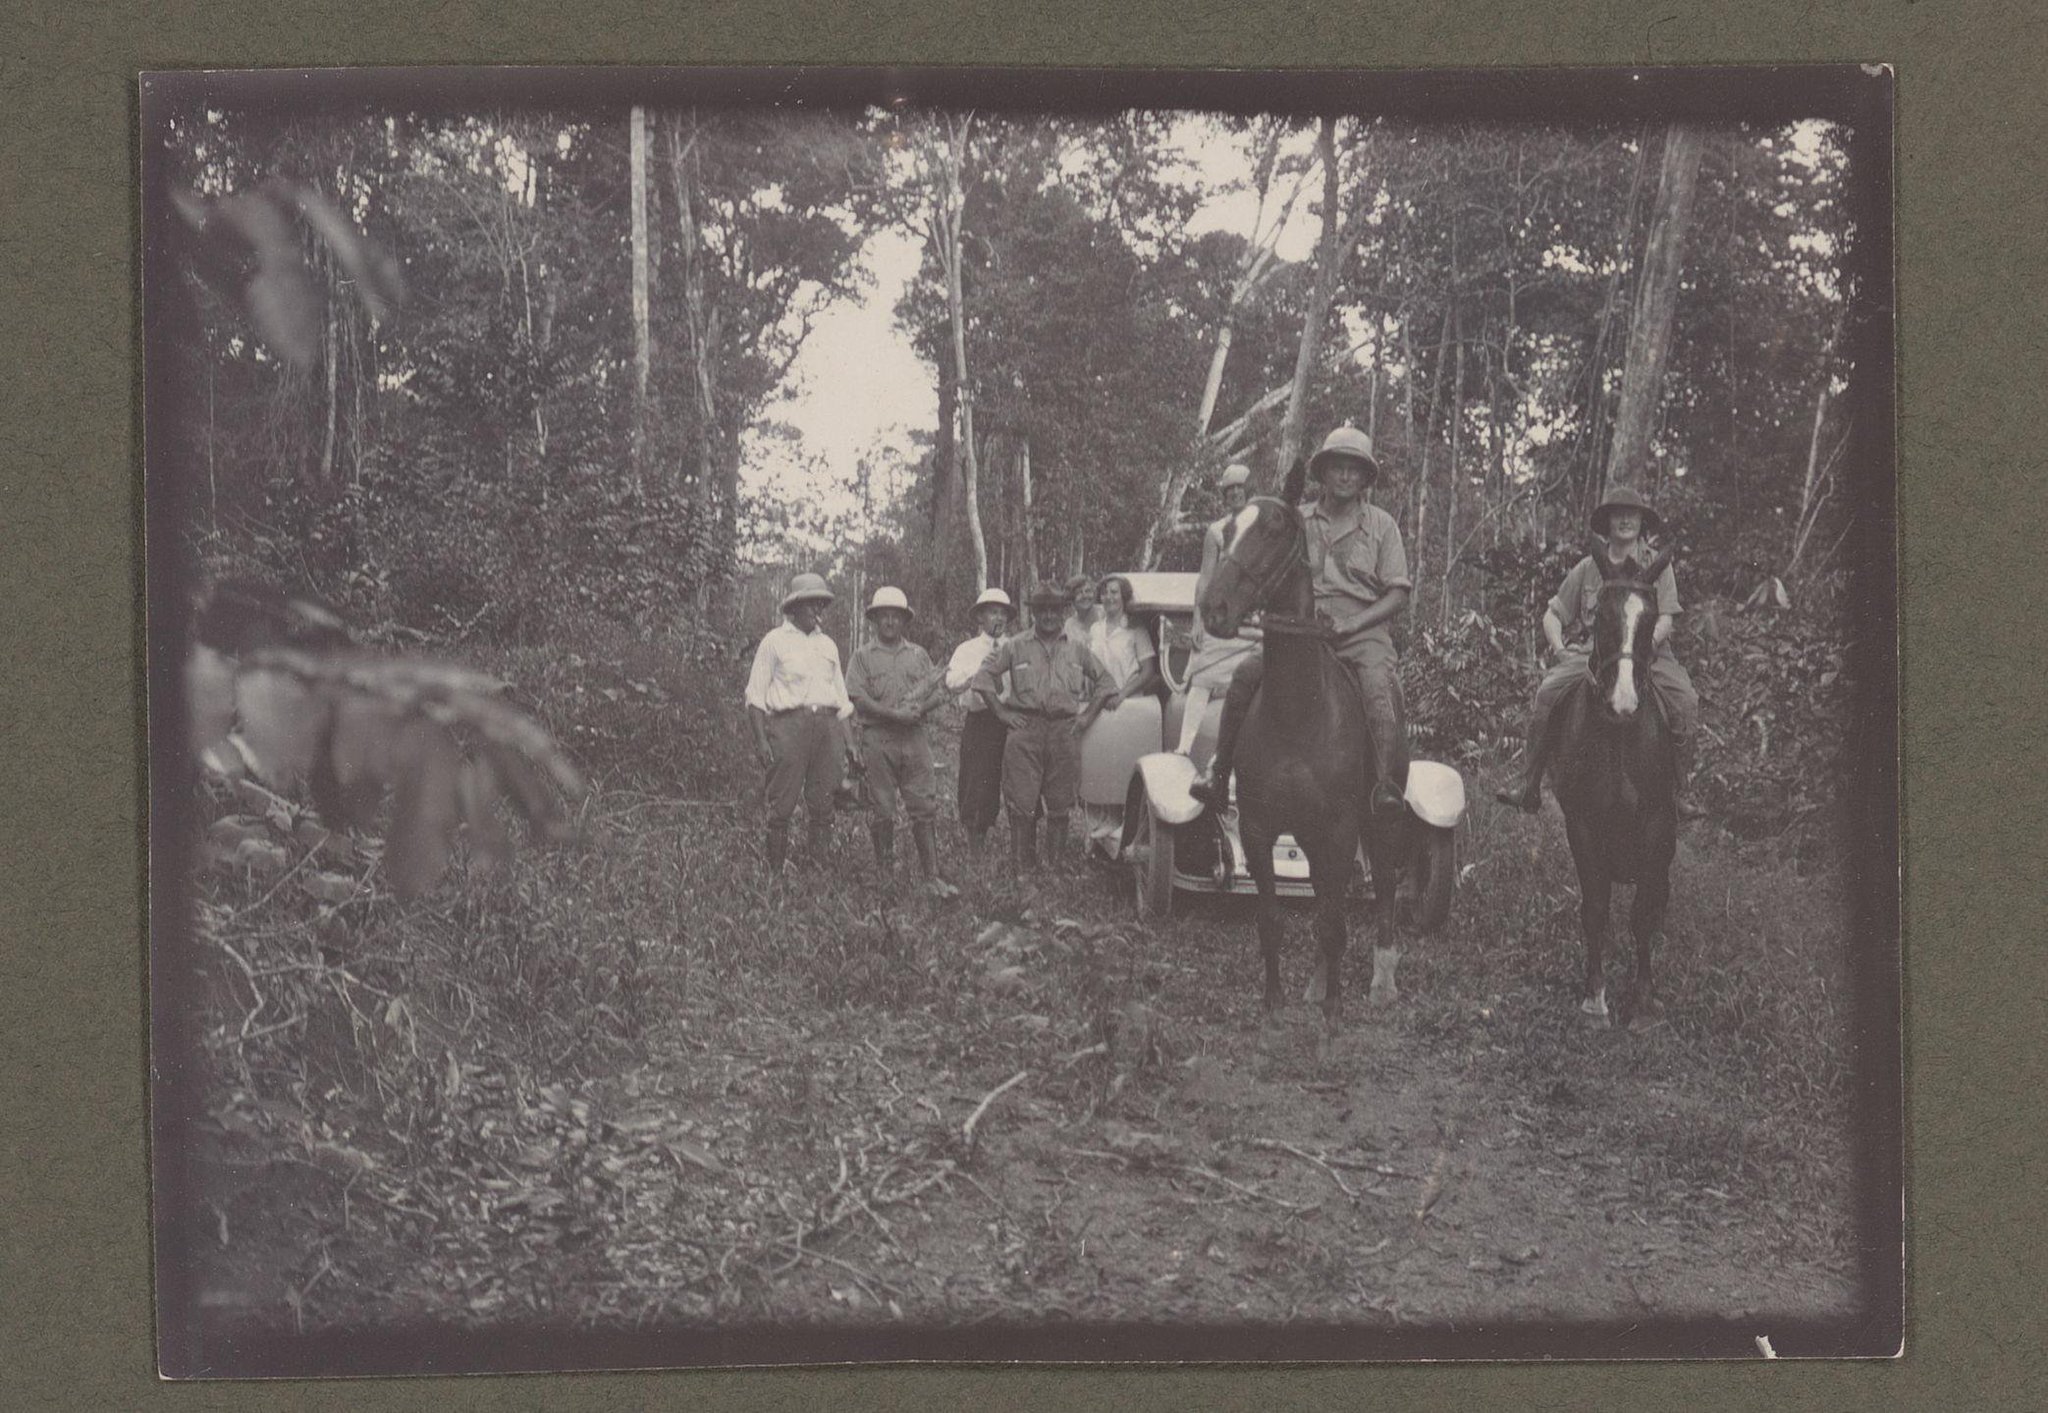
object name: photograph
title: Bezoek aan een dorp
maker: Anonymous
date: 1925-1927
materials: photographic support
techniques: photography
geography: suriname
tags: jetten, familie, moengo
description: Bezoek aan een inlands dorp door een groep Nederlanders waaronder het echtpaar Jetten. Foto op een bladzijde van een los albumblad. Onderdeel van het ensemble met foto's van de familie van ingenieur Jetten in de mijnbouwstad Moengo in Suriname.